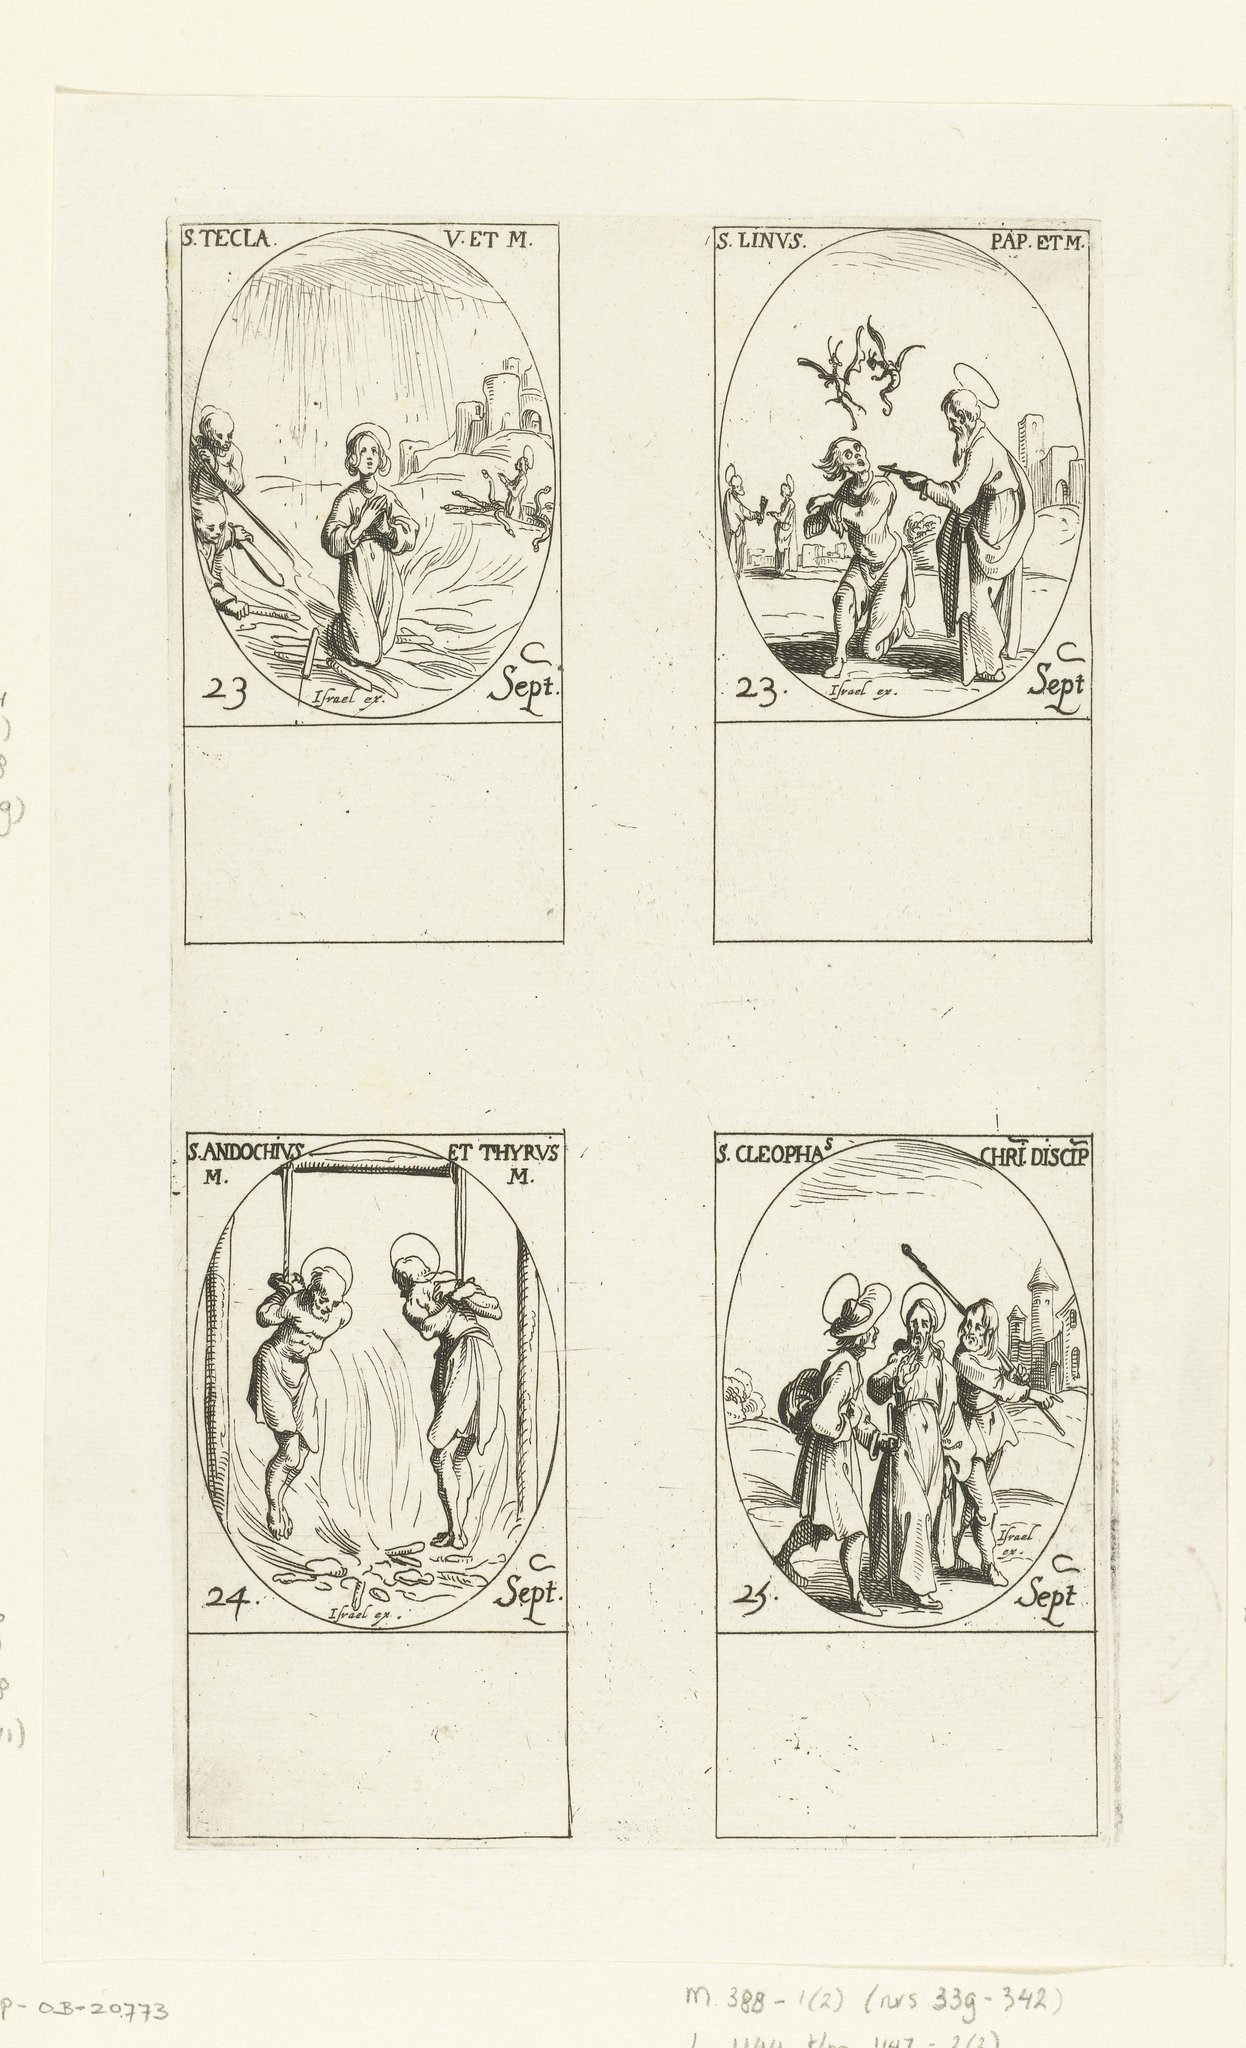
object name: print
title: Alle heiligen en de Christelijke feestdagen van het jaar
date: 1632-1636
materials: paper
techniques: etching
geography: paris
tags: the journey to emmaus: two disciples (cleopas and peter) under way, male saints (with name), st. thecla is tied to the stake, but the flames do not harm her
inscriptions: collector's mark: Lugt 240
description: Blad met vier ovale voorstellingen, elk met opschrift en datum in het Latijn: linksboven de Heilige Thecla van Iconium op een brandstapel, rechtsboven de Heilige Linus die duivels uitdrijft, linksonder de Heilige Andochius en de Heilige Thyrsus hangend aan hun armen boven een brandstapel, rechtsonder de Heilige Kleopas wandelend naast Christus en een andere reiziger. Deze prent is onderdeel van een serie prenten met voorstellingen van de heiligen en de christelijke feestdagen van het jaar. Er zijn steeds vier scènes van één plaat op één blad gedrukt. Inclusief bijbehorend titelblad en frontispice gaat het in totaal om 124 platen (490 voorstellingen). De drie platen met de laatste 12 scènes (de veranderlijke christelijke feestdagen) zijn in de derde staat versneden tot 12 kleine plaatjes, en met een apart titelblad uitgegeven.